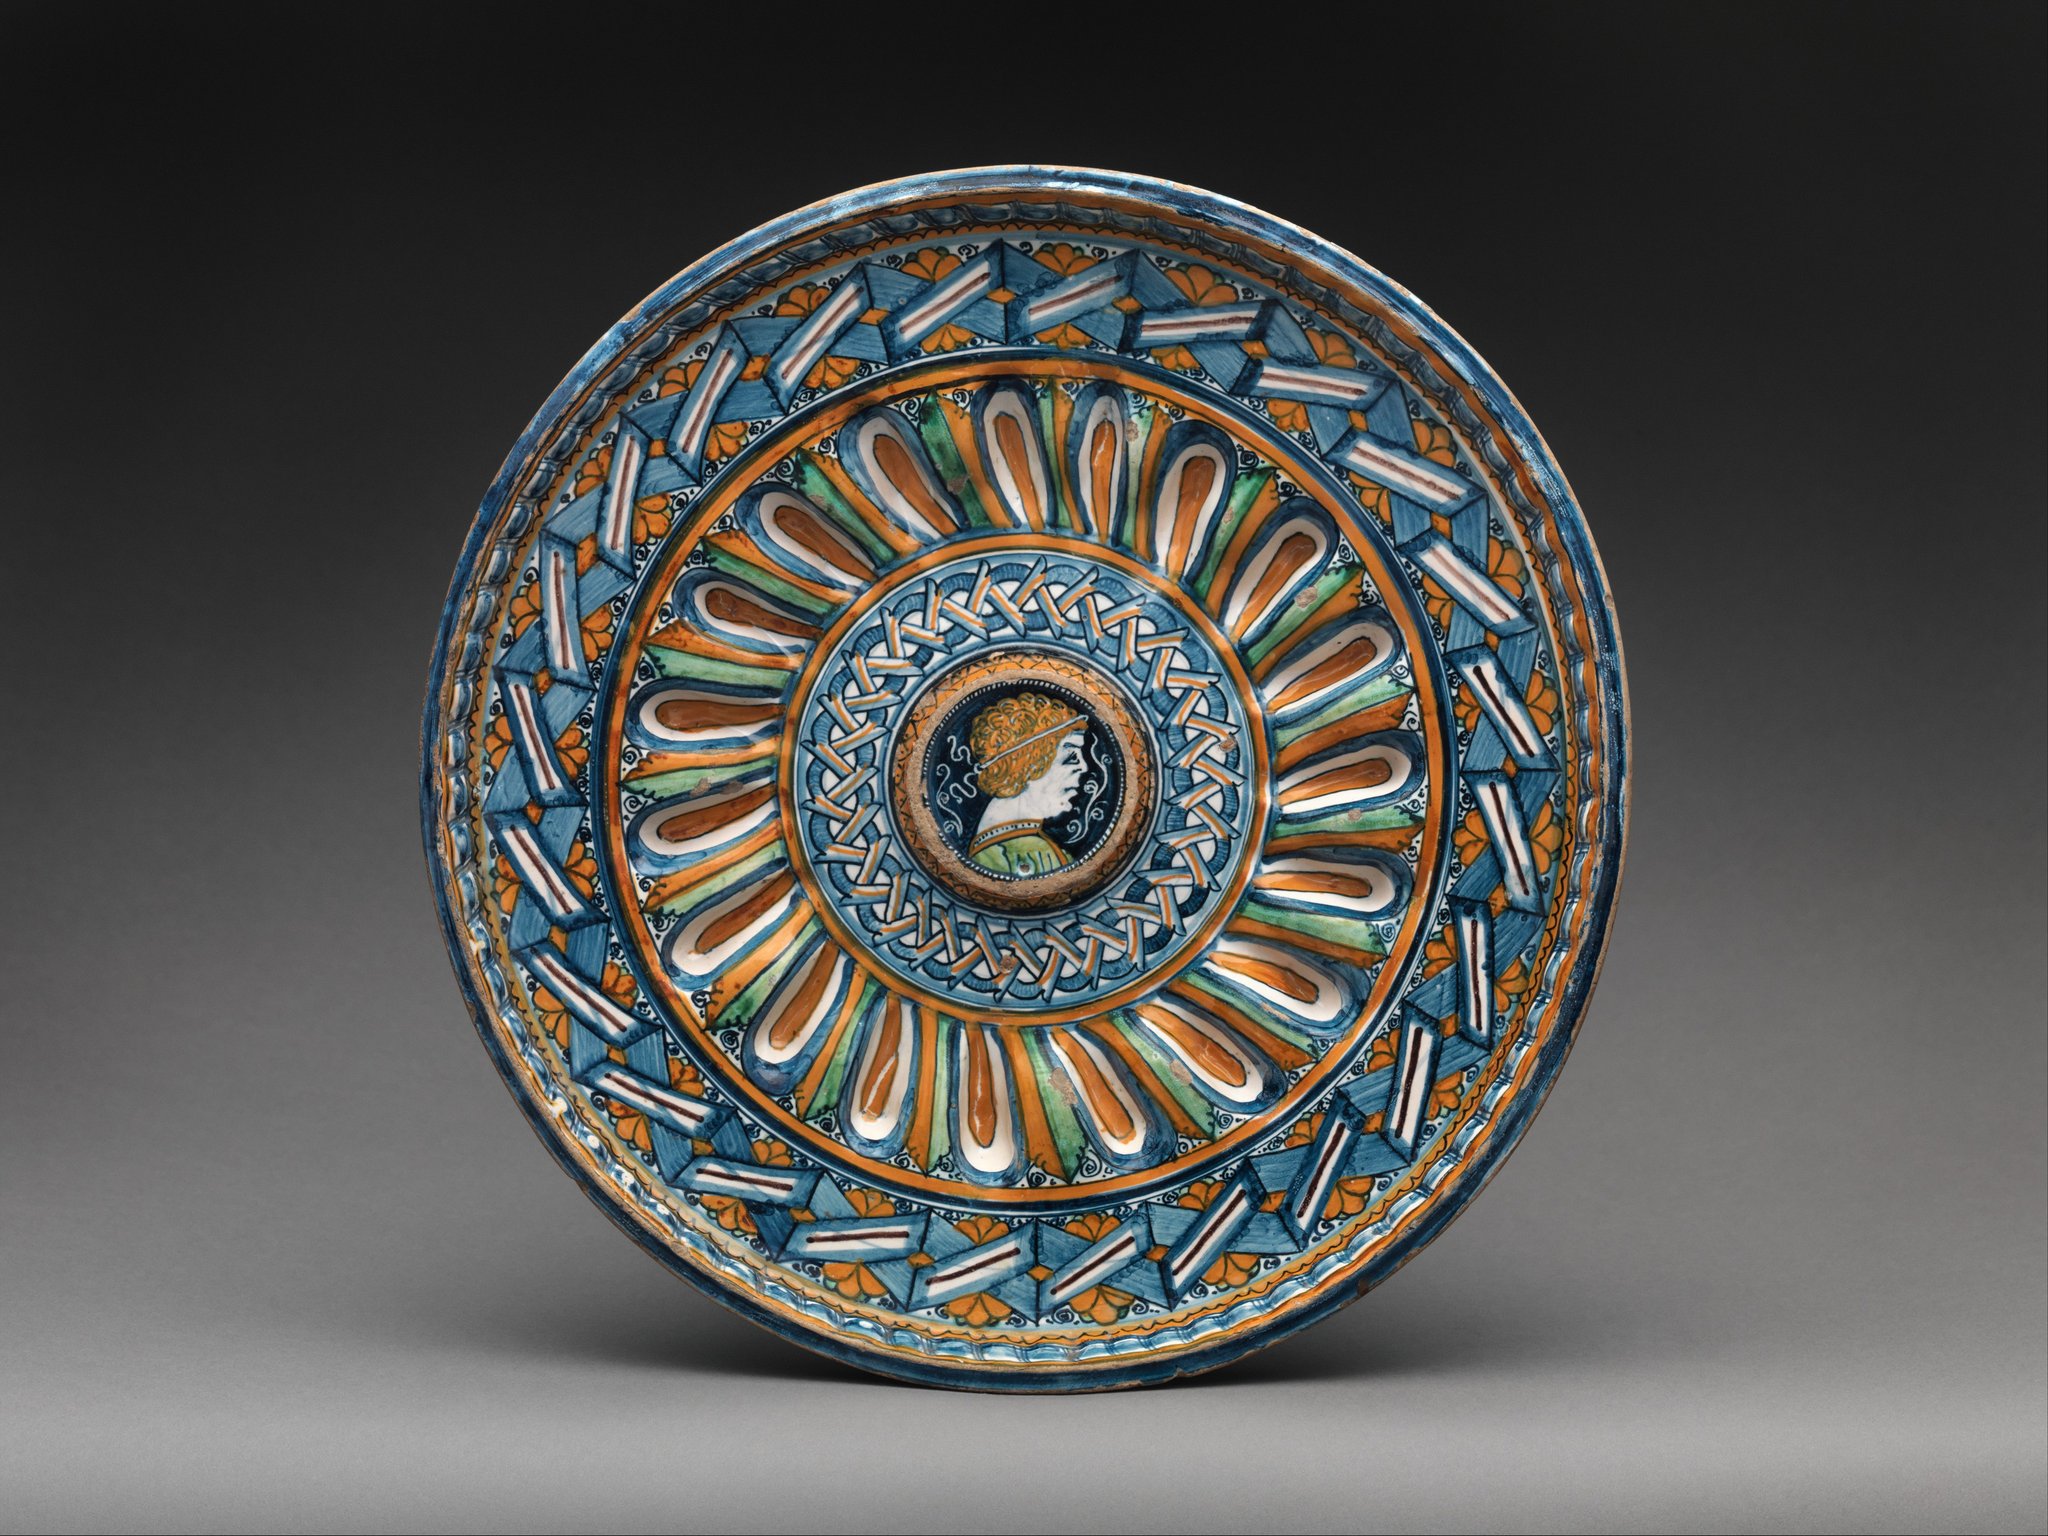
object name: basin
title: Basin with classicizing head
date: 1500-1510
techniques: maiolica, glazing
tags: men